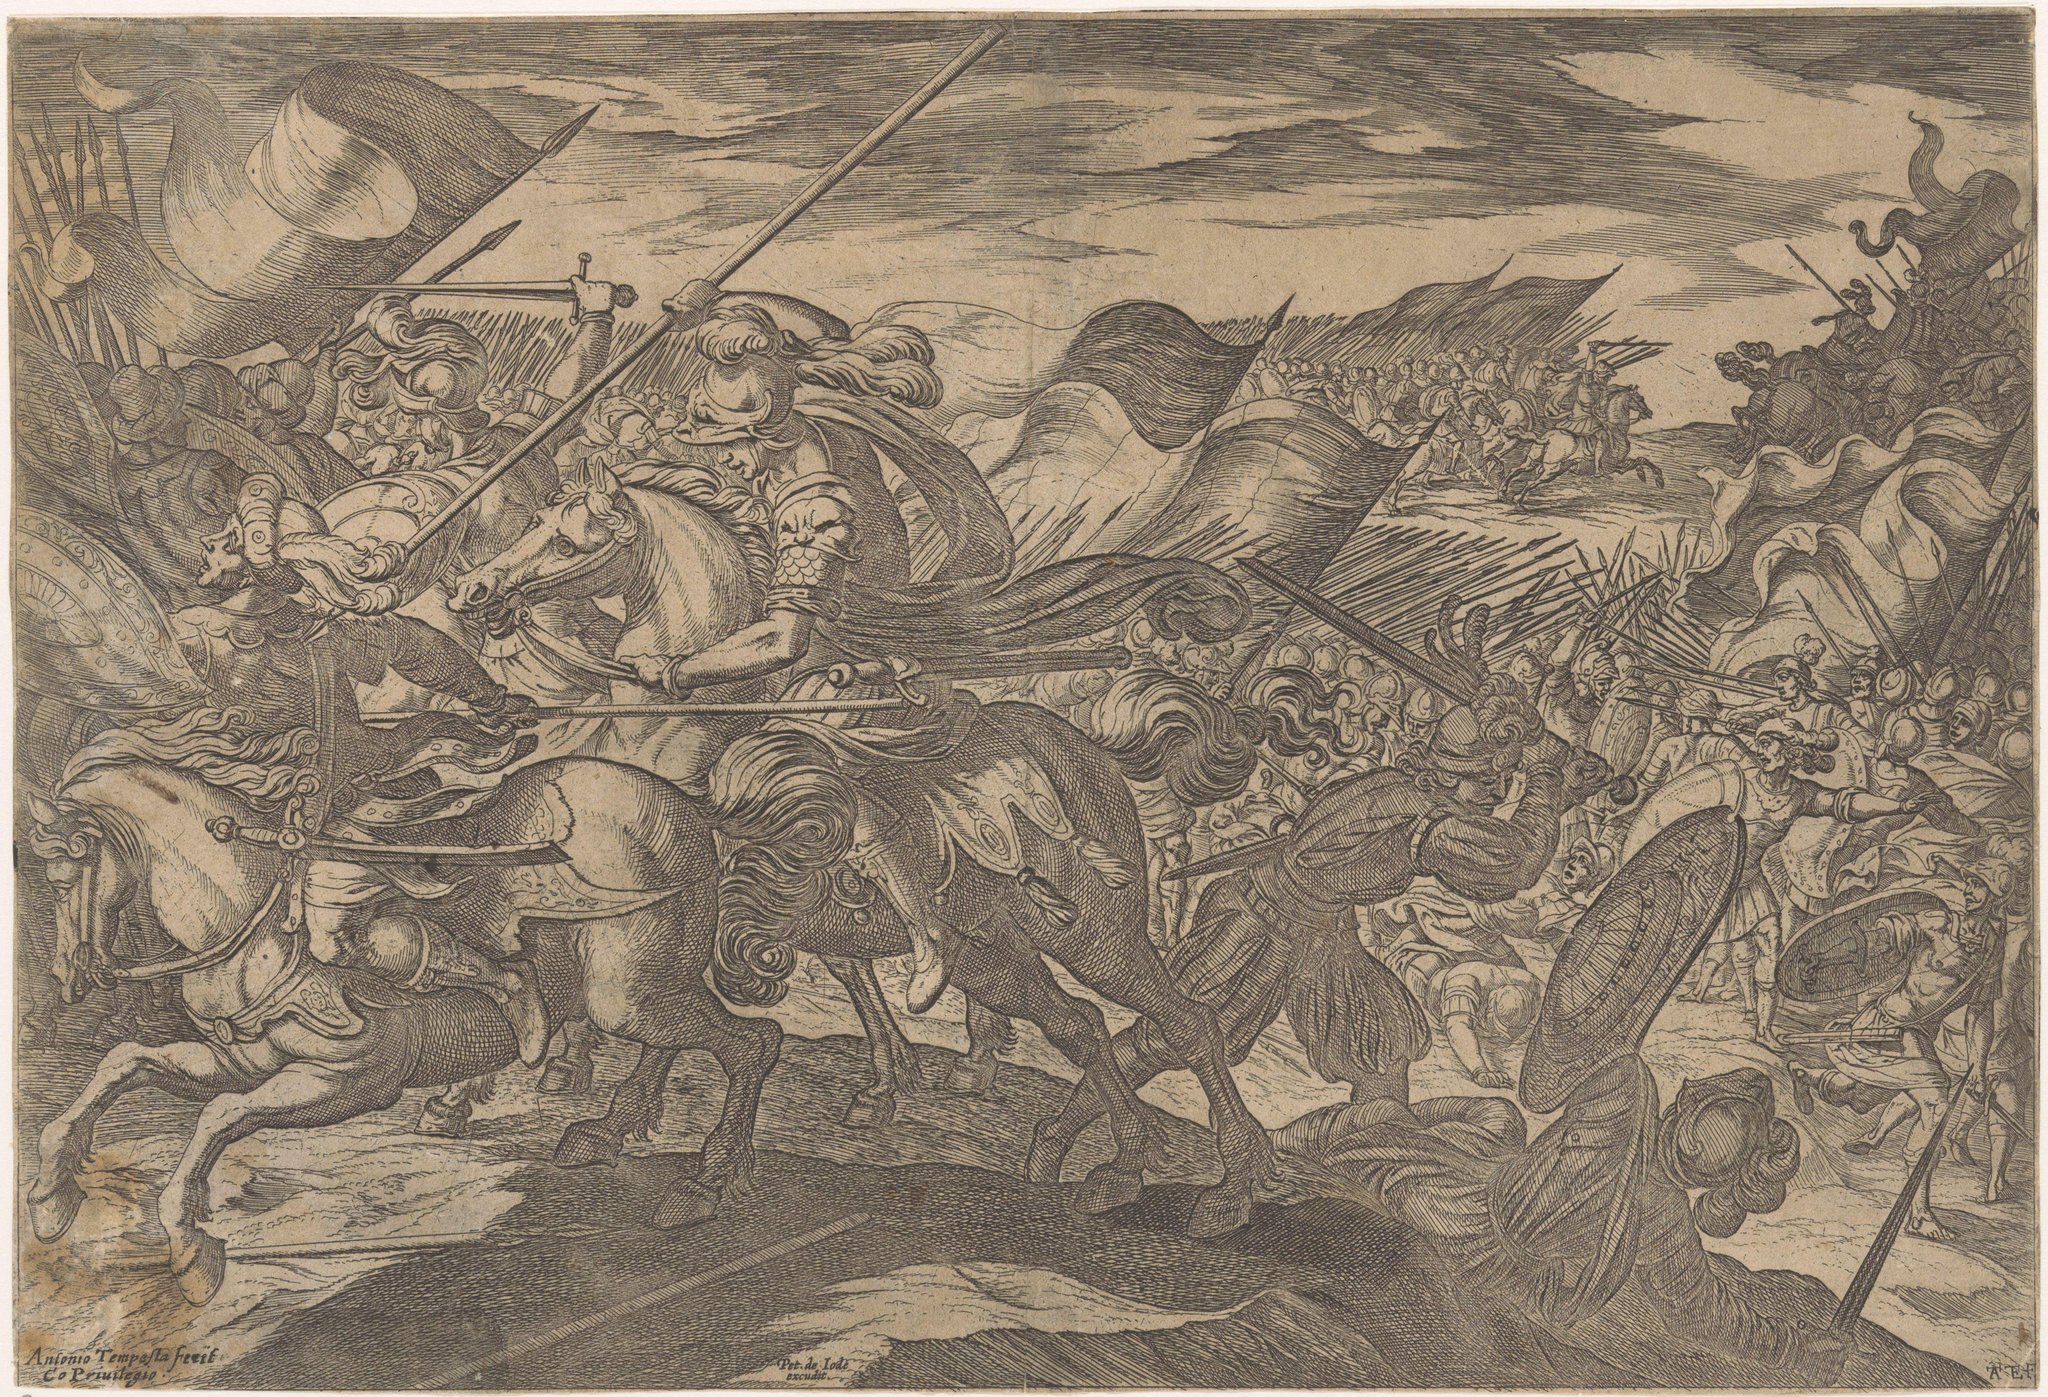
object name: print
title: Gevechtsscènes (serie 3)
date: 1601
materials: paper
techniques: etching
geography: rome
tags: battle, warfare; military affairs (+ cavalry, horsemen), the soldier; the soldier's life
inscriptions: collector's mark: Lugt 11, collector's mark: ‘Hinloopen’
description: Deze prent maakt deel uit van een reeks van acht prenten (+ titelprent). Ondermarge met tekst is afgesneden.